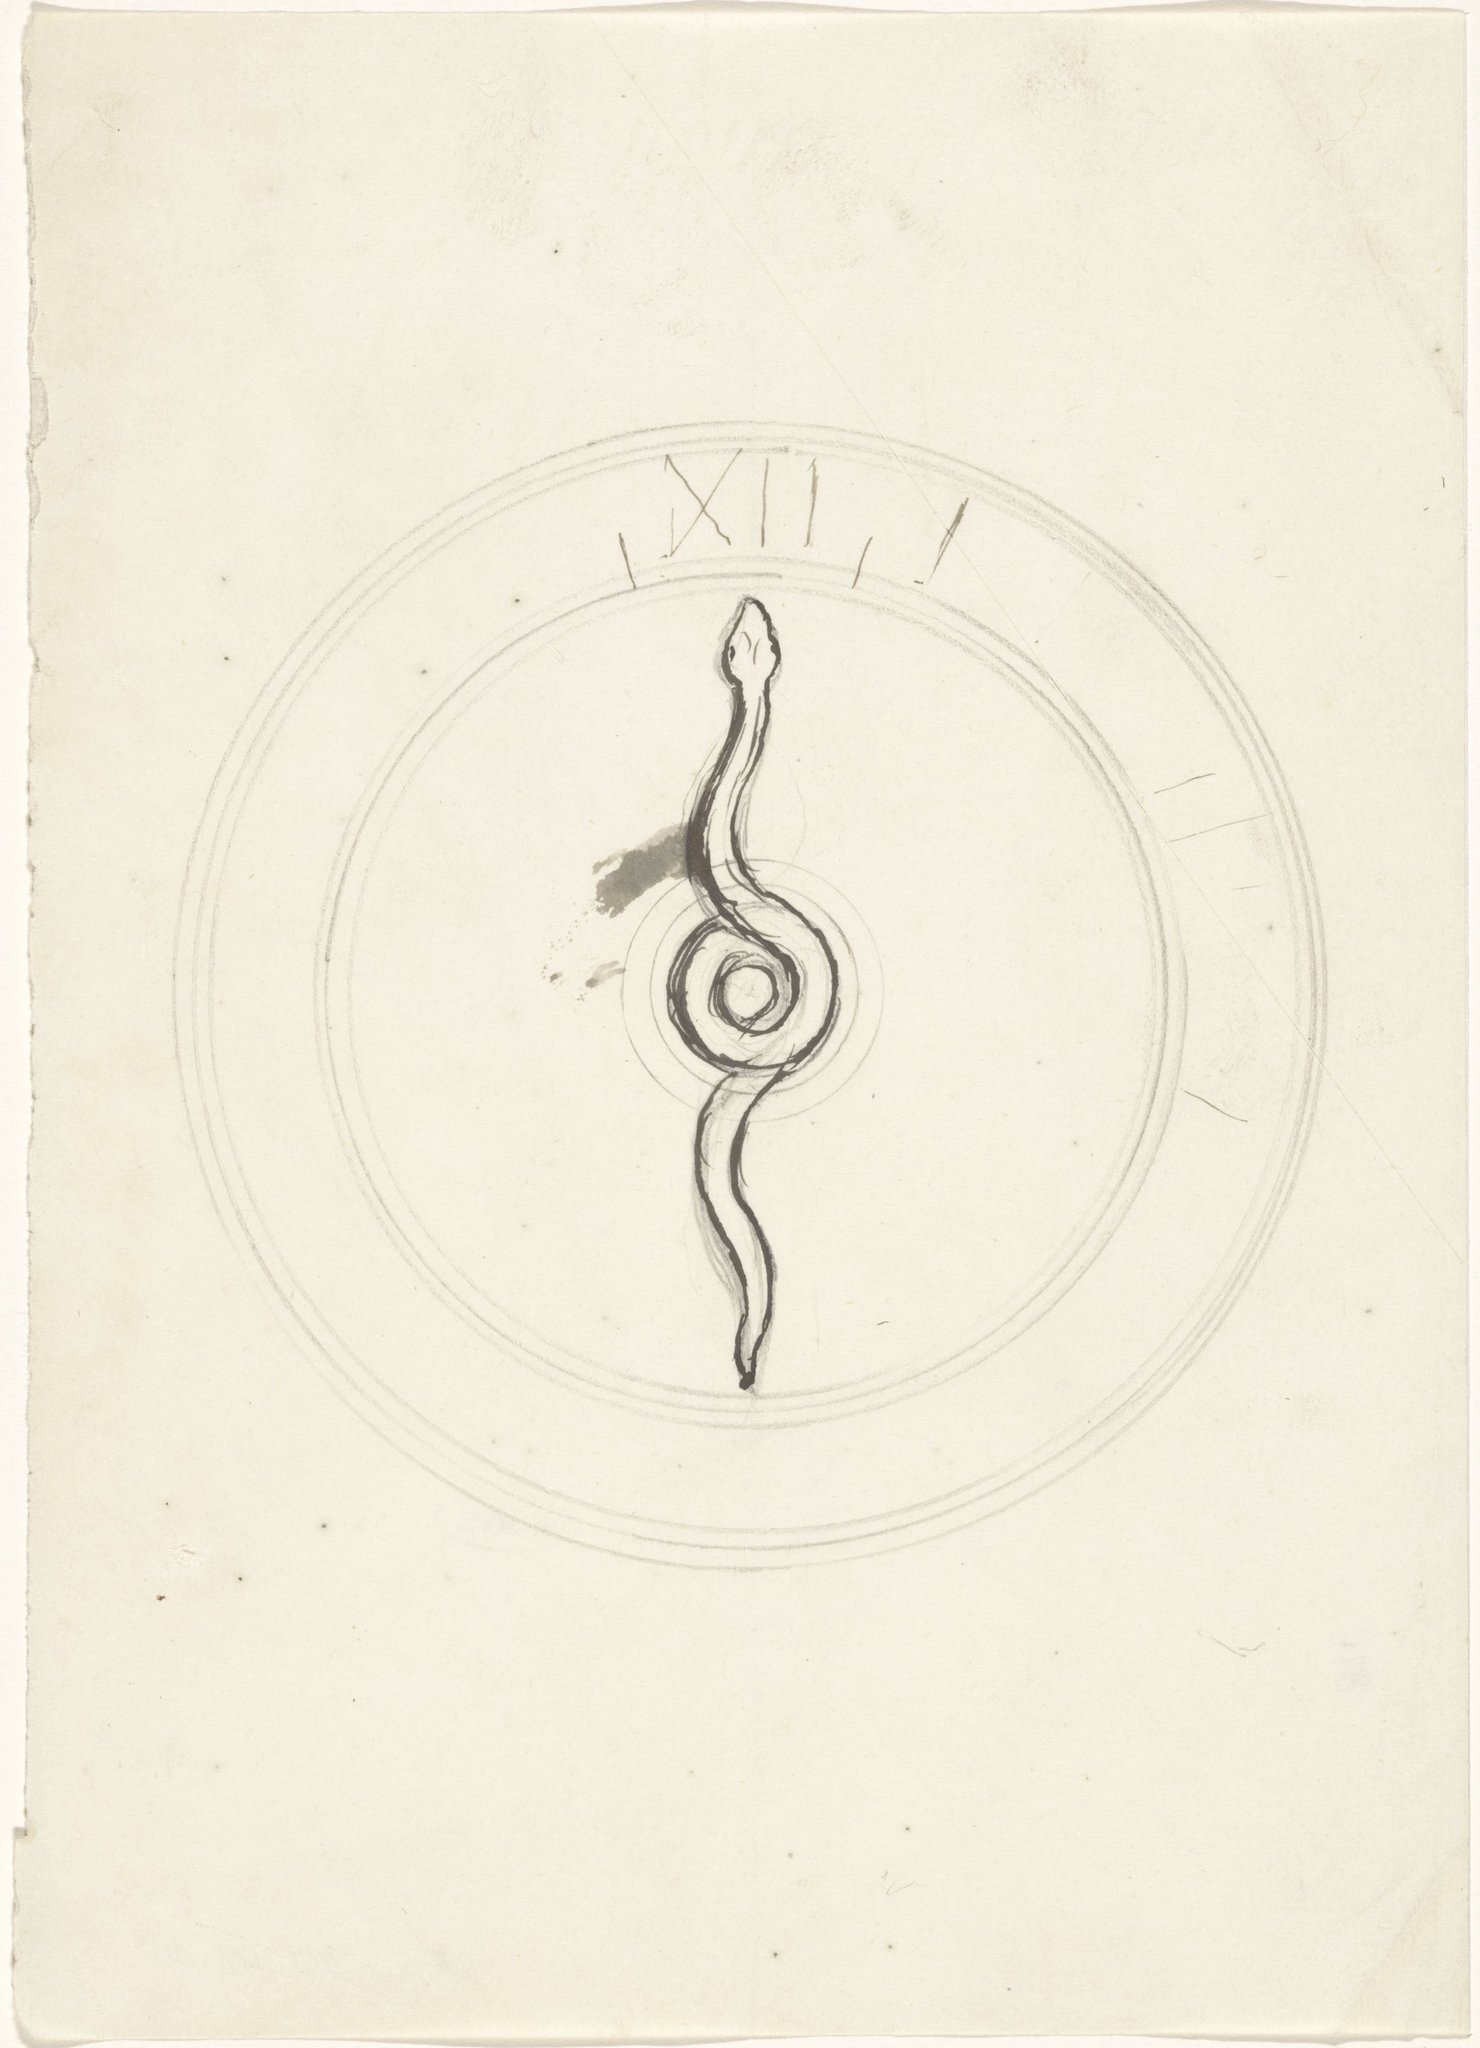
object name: design drawing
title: Ontwerp voor een wijzerplaat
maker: giuseppe valadier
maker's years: 1762-1839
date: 1800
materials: graphite, paper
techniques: pen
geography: rome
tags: clock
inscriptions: watermark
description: Ontwerp voor een wijzerplaat met de cijfers XII en I, met wijzers in de vorm van een slang.